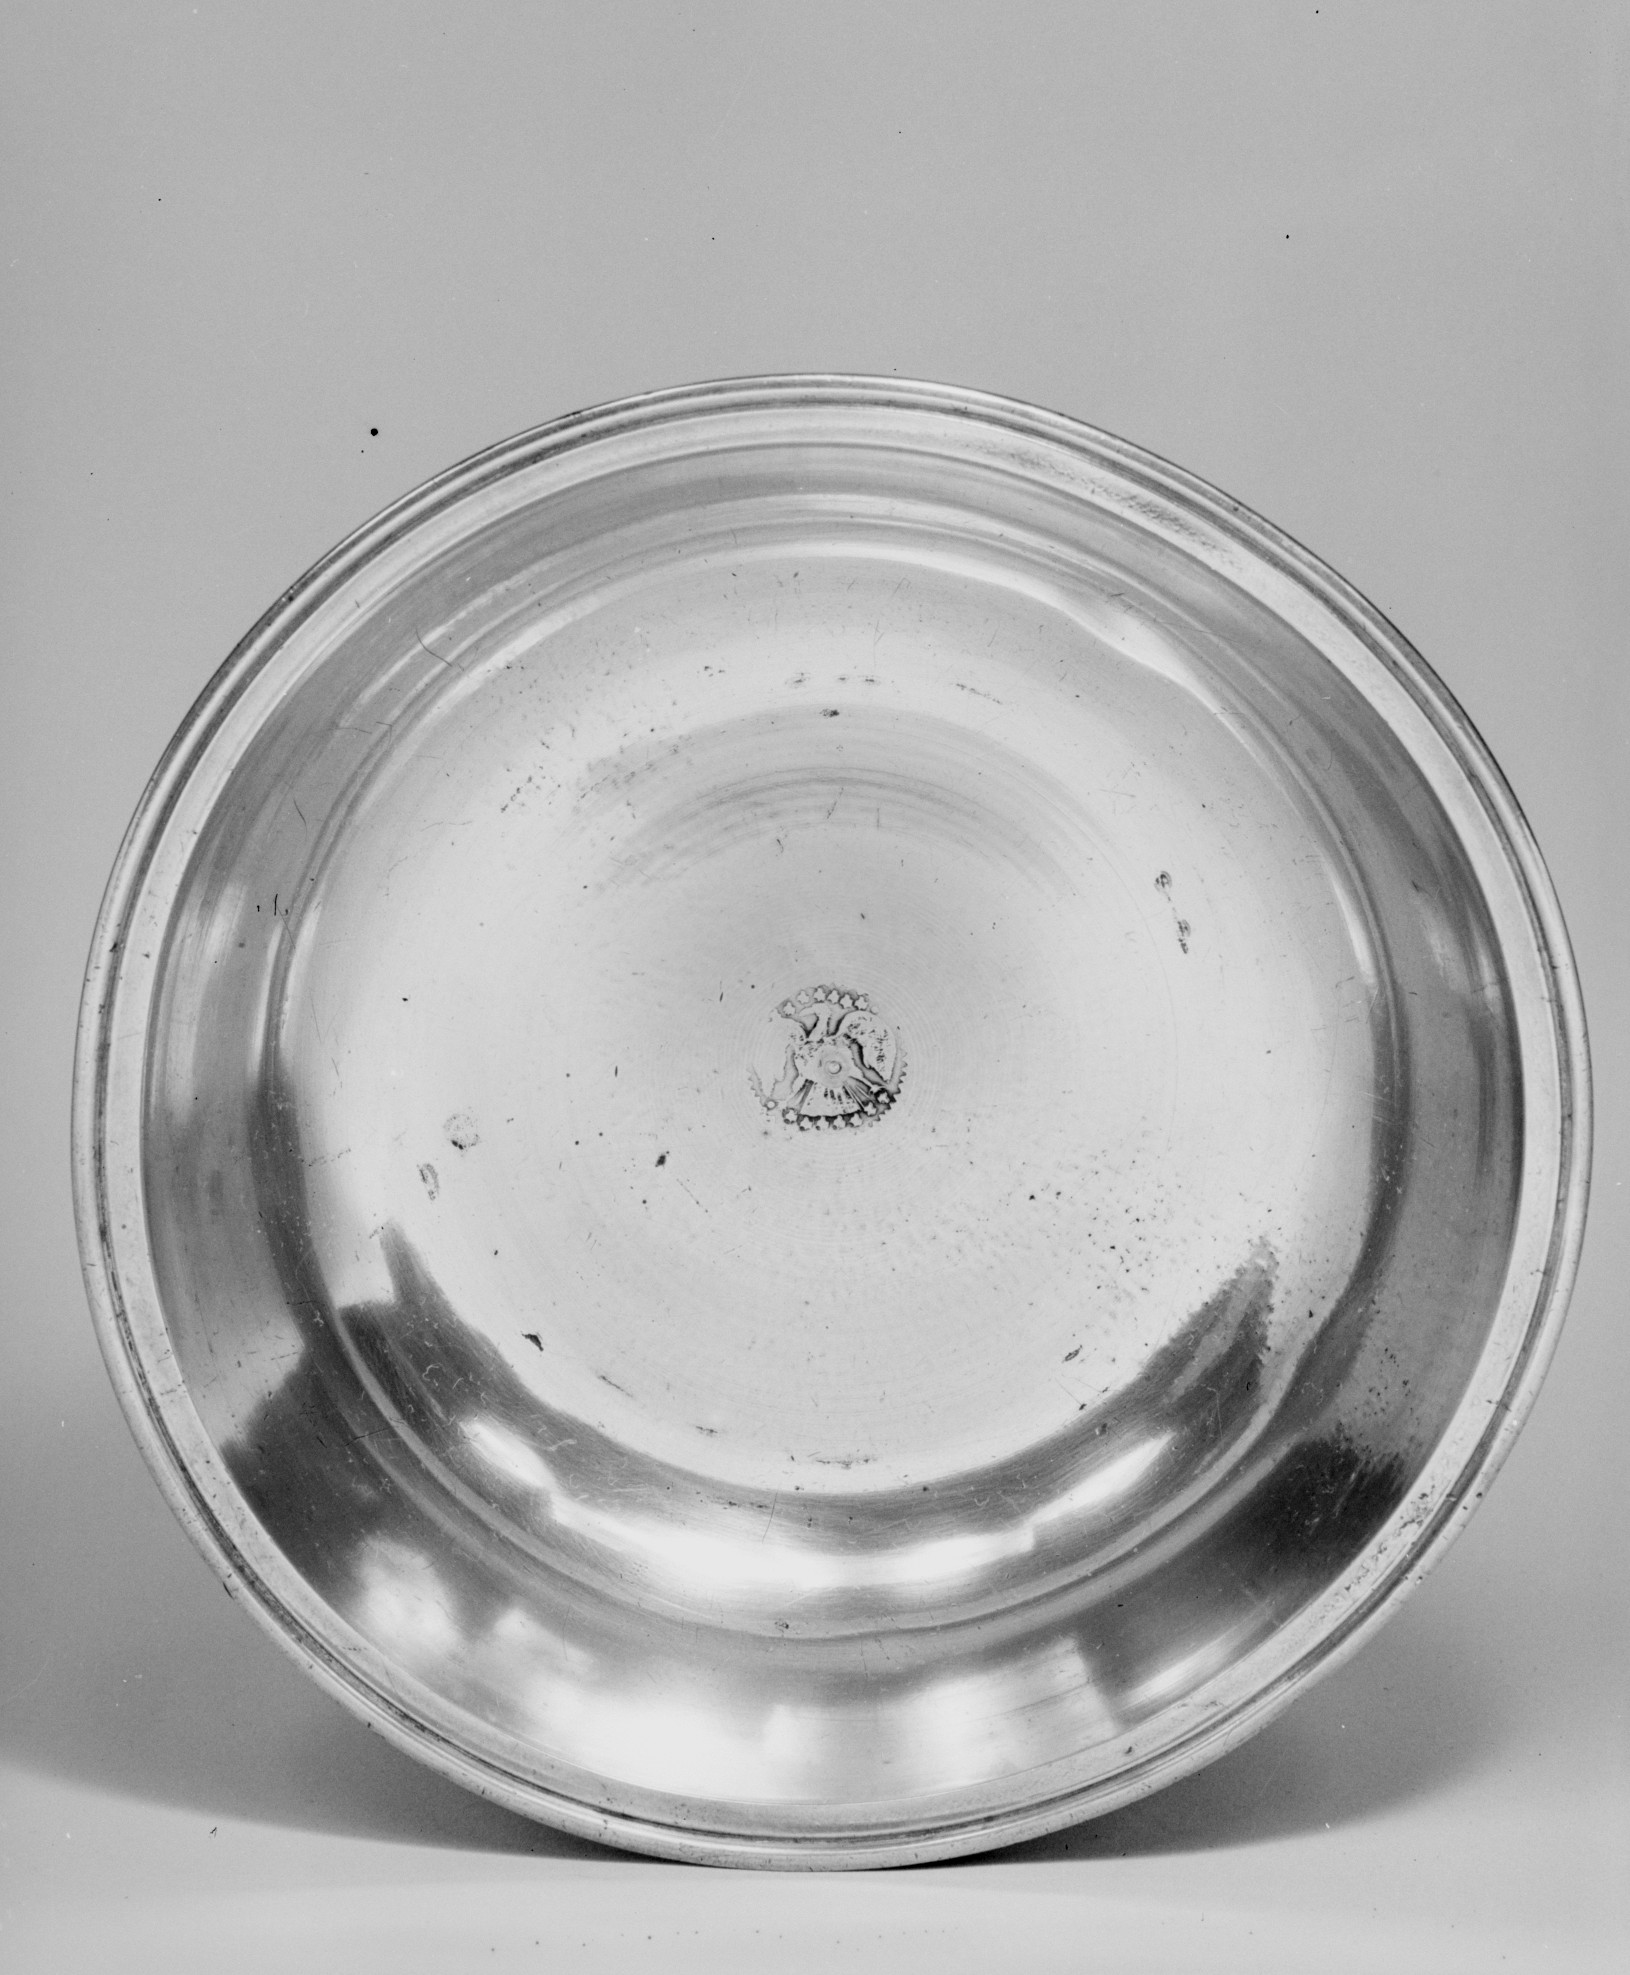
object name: basin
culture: american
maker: gershom jones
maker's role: maker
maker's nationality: american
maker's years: 1751-1809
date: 1800-1809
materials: pewter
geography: united states